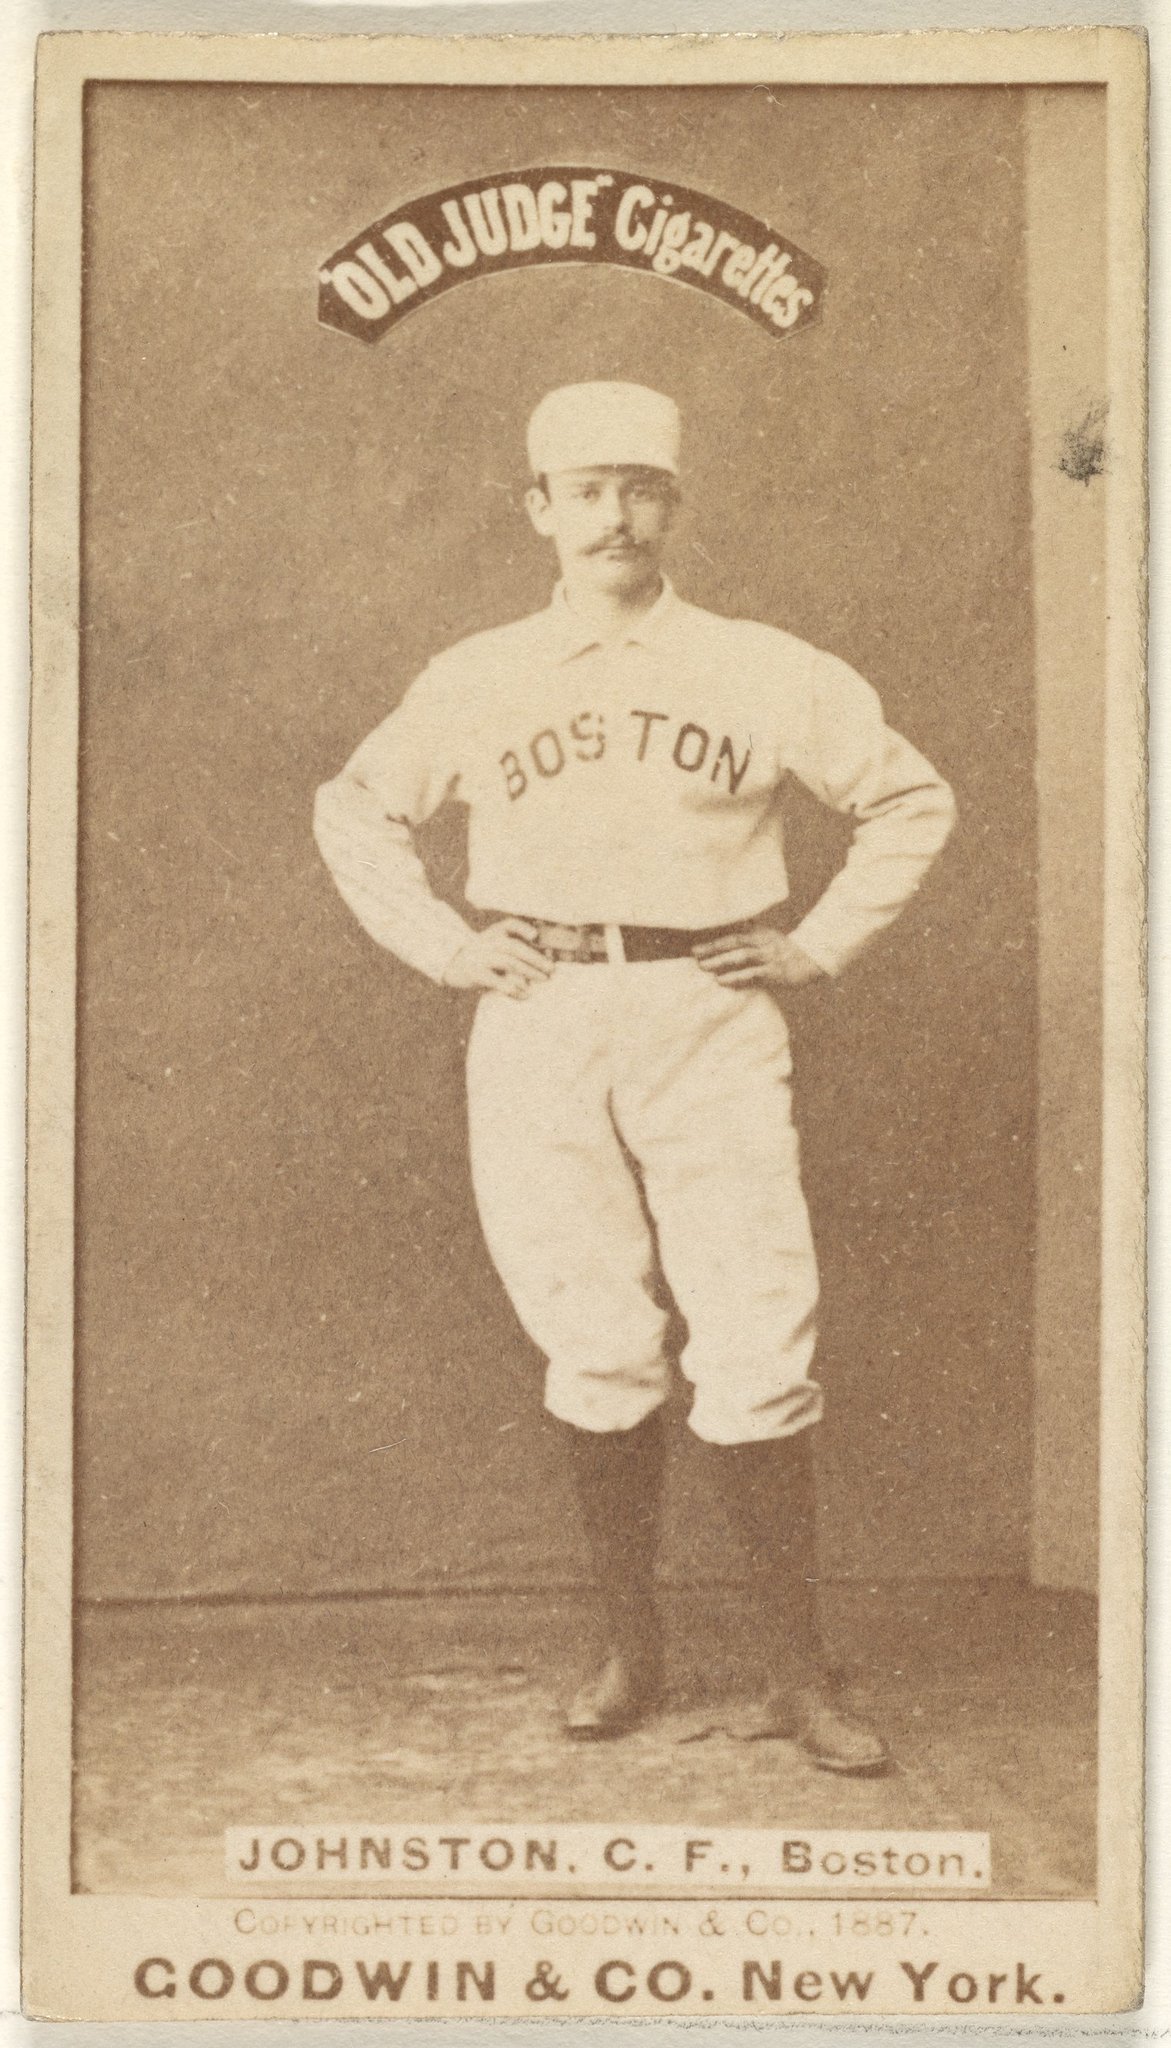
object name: baseball card, photograph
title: Johnston, Center Field, Boston, from the Old Judge series (N172) for Old Judge Cigarettes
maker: goodwin & company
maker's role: publisher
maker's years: 1850-1950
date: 1887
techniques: albumen silver print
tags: men,portraits,baseball,athletes